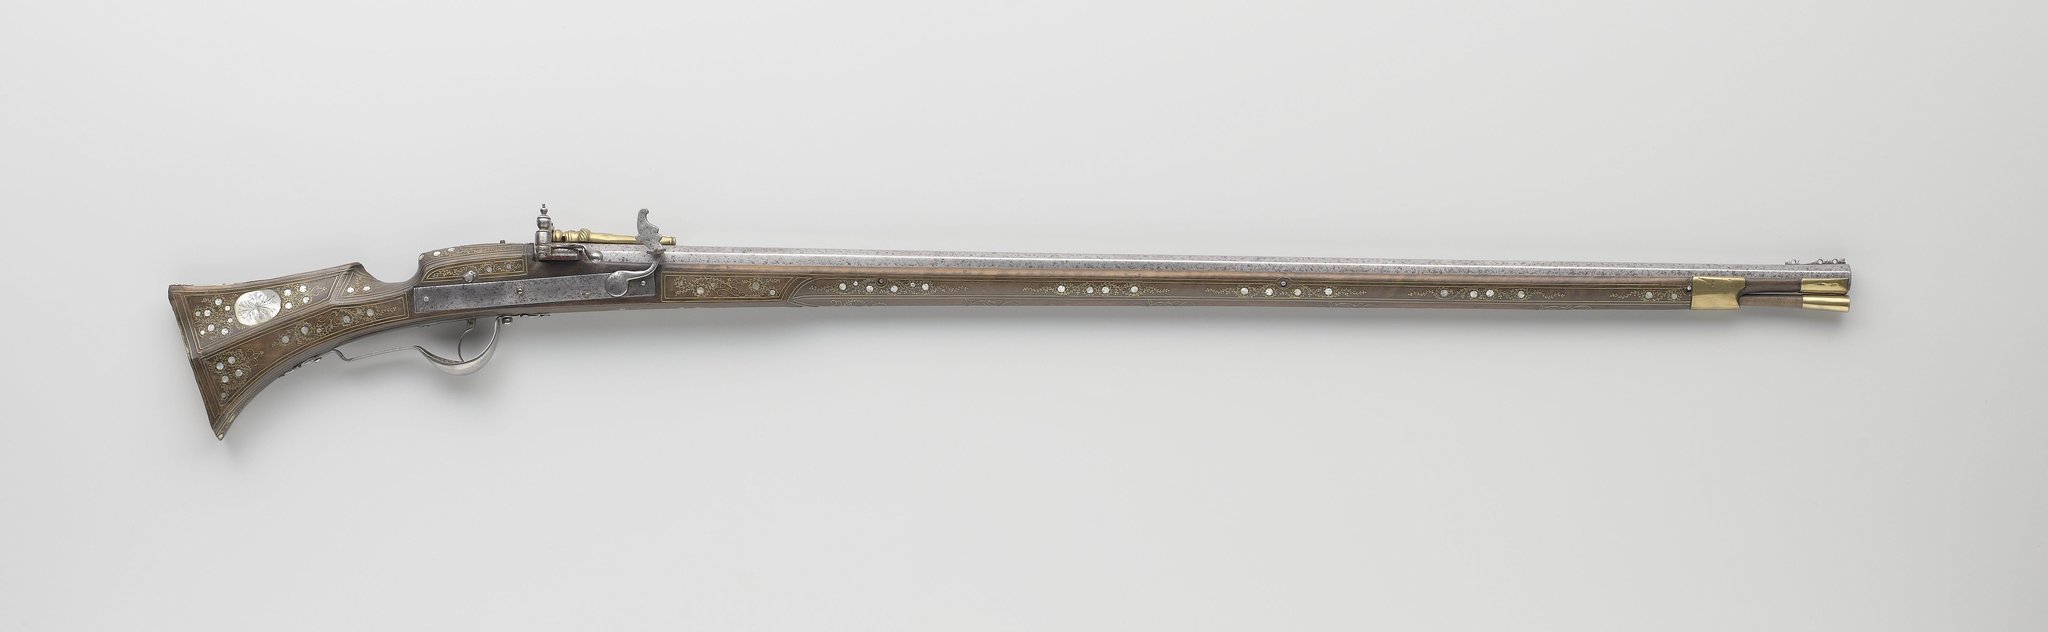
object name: musket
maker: Anonymous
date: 1625-1650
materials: brass, iron, mother of pearl, wood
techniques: cutting, engraving, forging, striking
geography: low countries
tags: ornaments ~ art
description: Caliver, probably made in the Netherlands, second quarter 17th century.